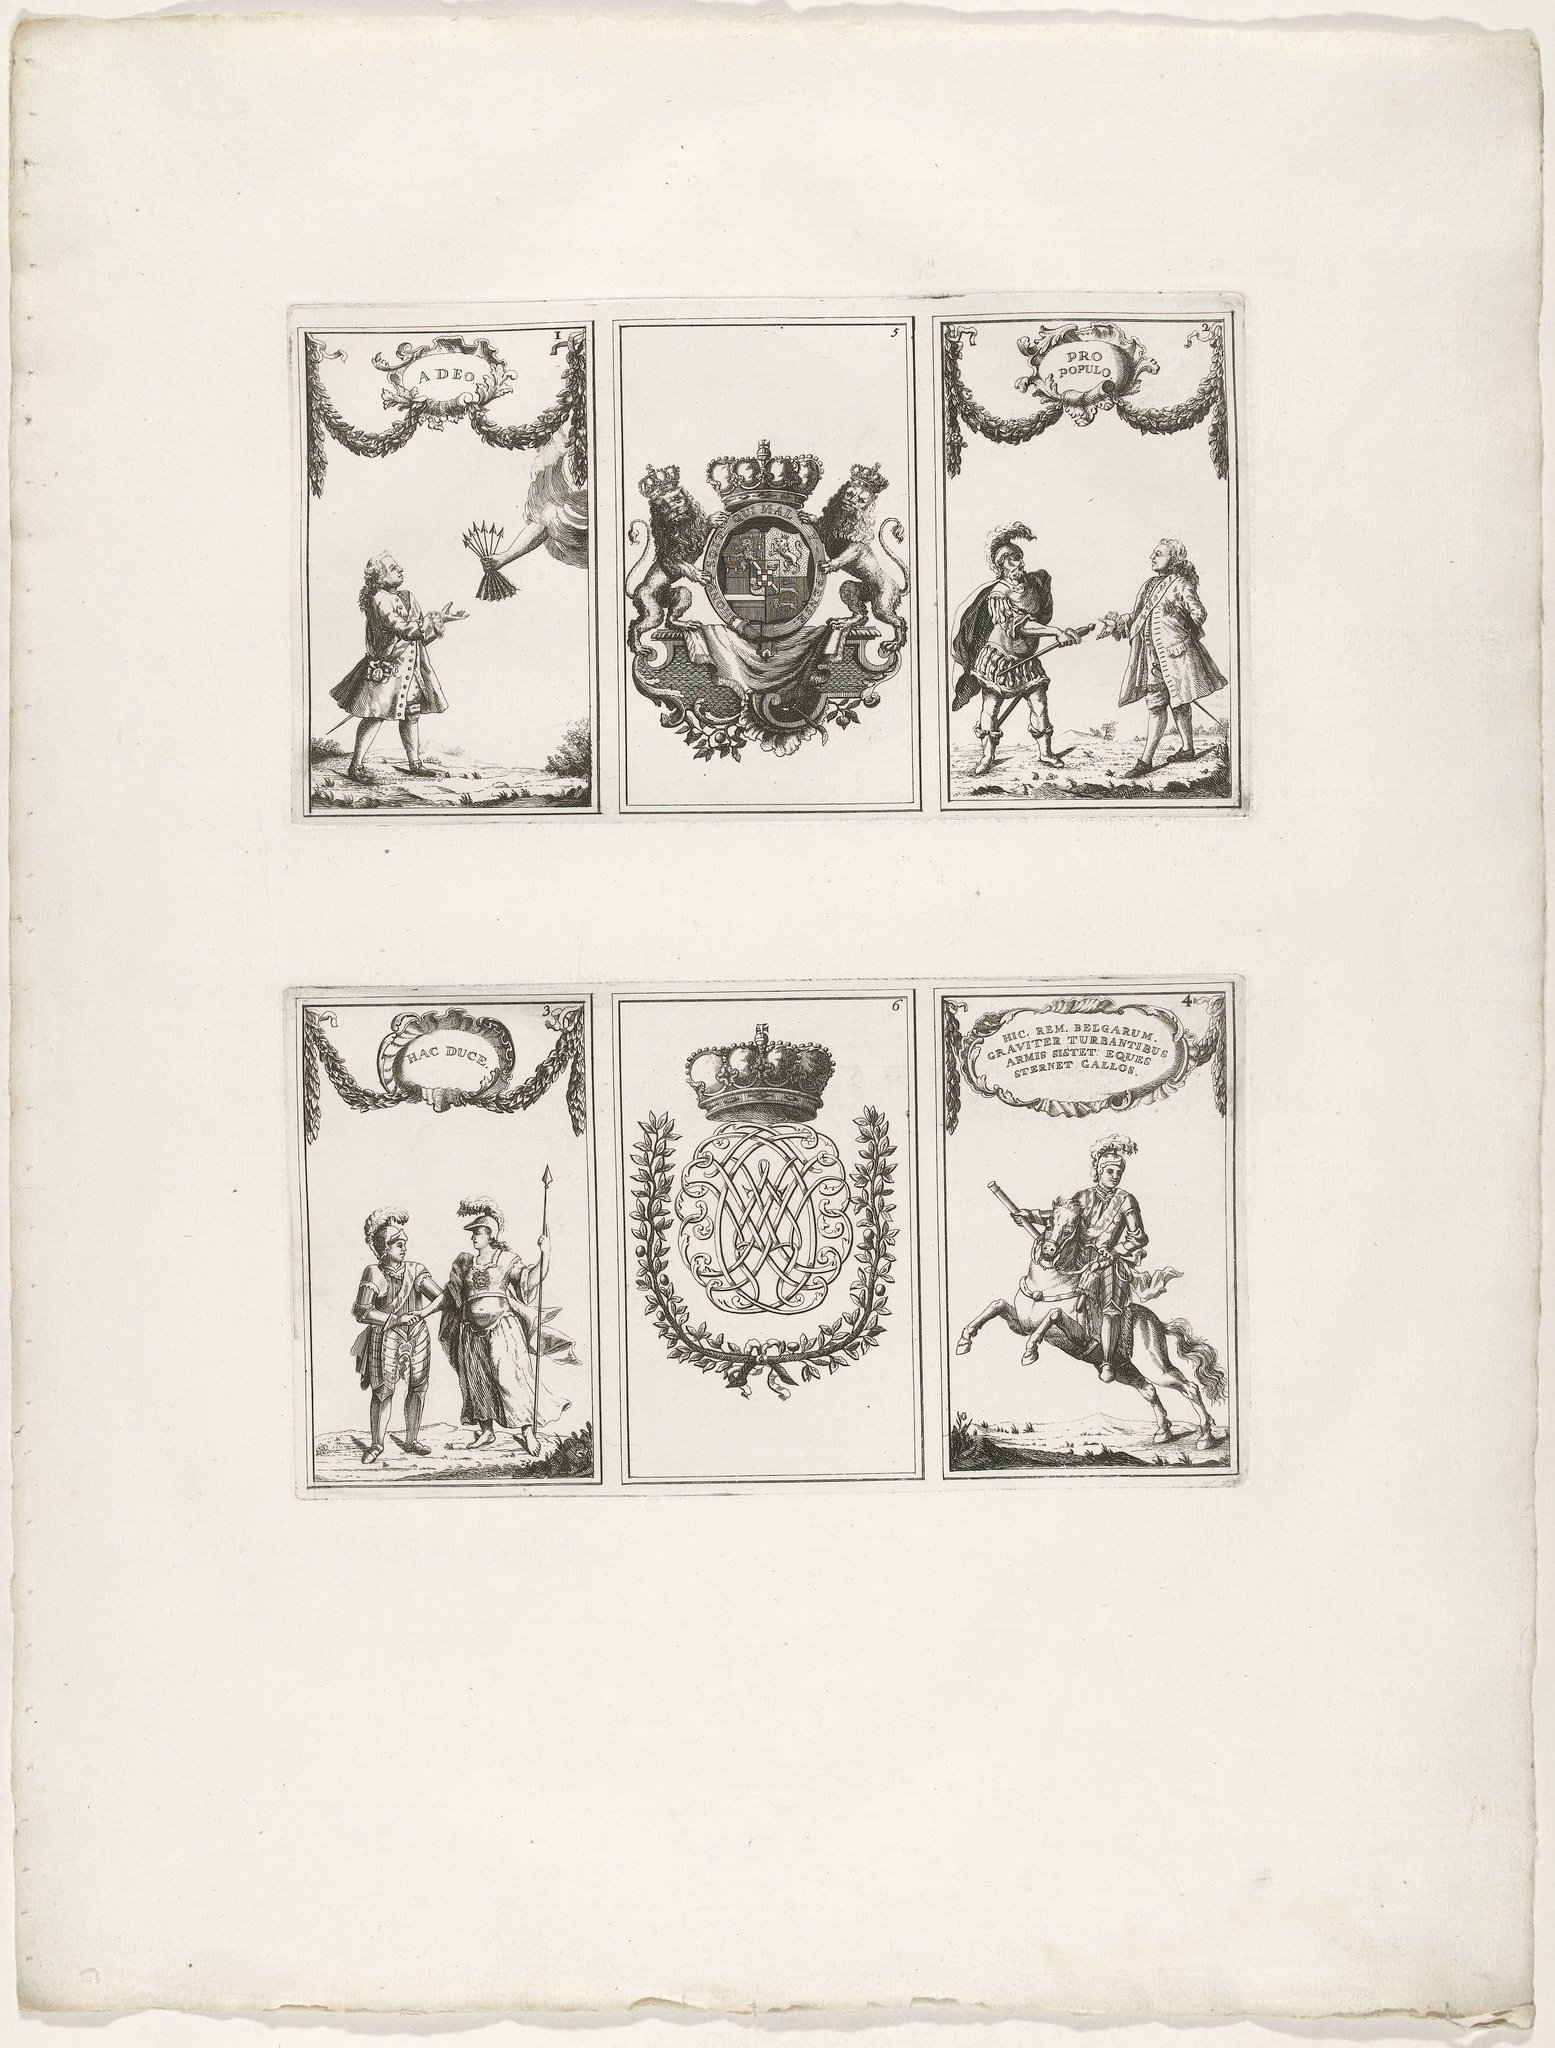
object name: print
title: Haga comitis illustrata; of het verheerlykt en verligt 's Gravenhage bestaende in eene (...) verzameling van 116 (...) in het koper gebragte afbeeldingen, der (...) geillumineerd geweest zynde decoratien en zinnebeelden (...) ter geleegenheid der (...) verkiezinge, proclamatie & installatie van Z.D.H. Willem Carel Hendrik Friso, Prince van Oranje & Nassau, enz. tot Stadhouder (...) den 3 & 15 May 1747 : opgehelderd door een (...) beschryving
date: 1751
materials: paper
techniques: engraving, etching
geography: northern netherlands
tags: the hague, willem iv (prins van oranje-nassau), decoration and illumination of streets, squares, etc. (~ triumphal entry, etc.)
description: Blad met de decoraties aangeduid met de cijfers 1-6, opgehangen aan de huizen van inwoners van Den Haag. Los blad oorspronkelijk onderdeel van het plaatwerk Haga comitis illustrata uit 1751 met de versieringen opgesteld te Den Haag tijdens de feestelijkheden rond de installatie van prins Willem IV als stadhouder van Holland en West-Friesland op 3 en 15 mei 1747.